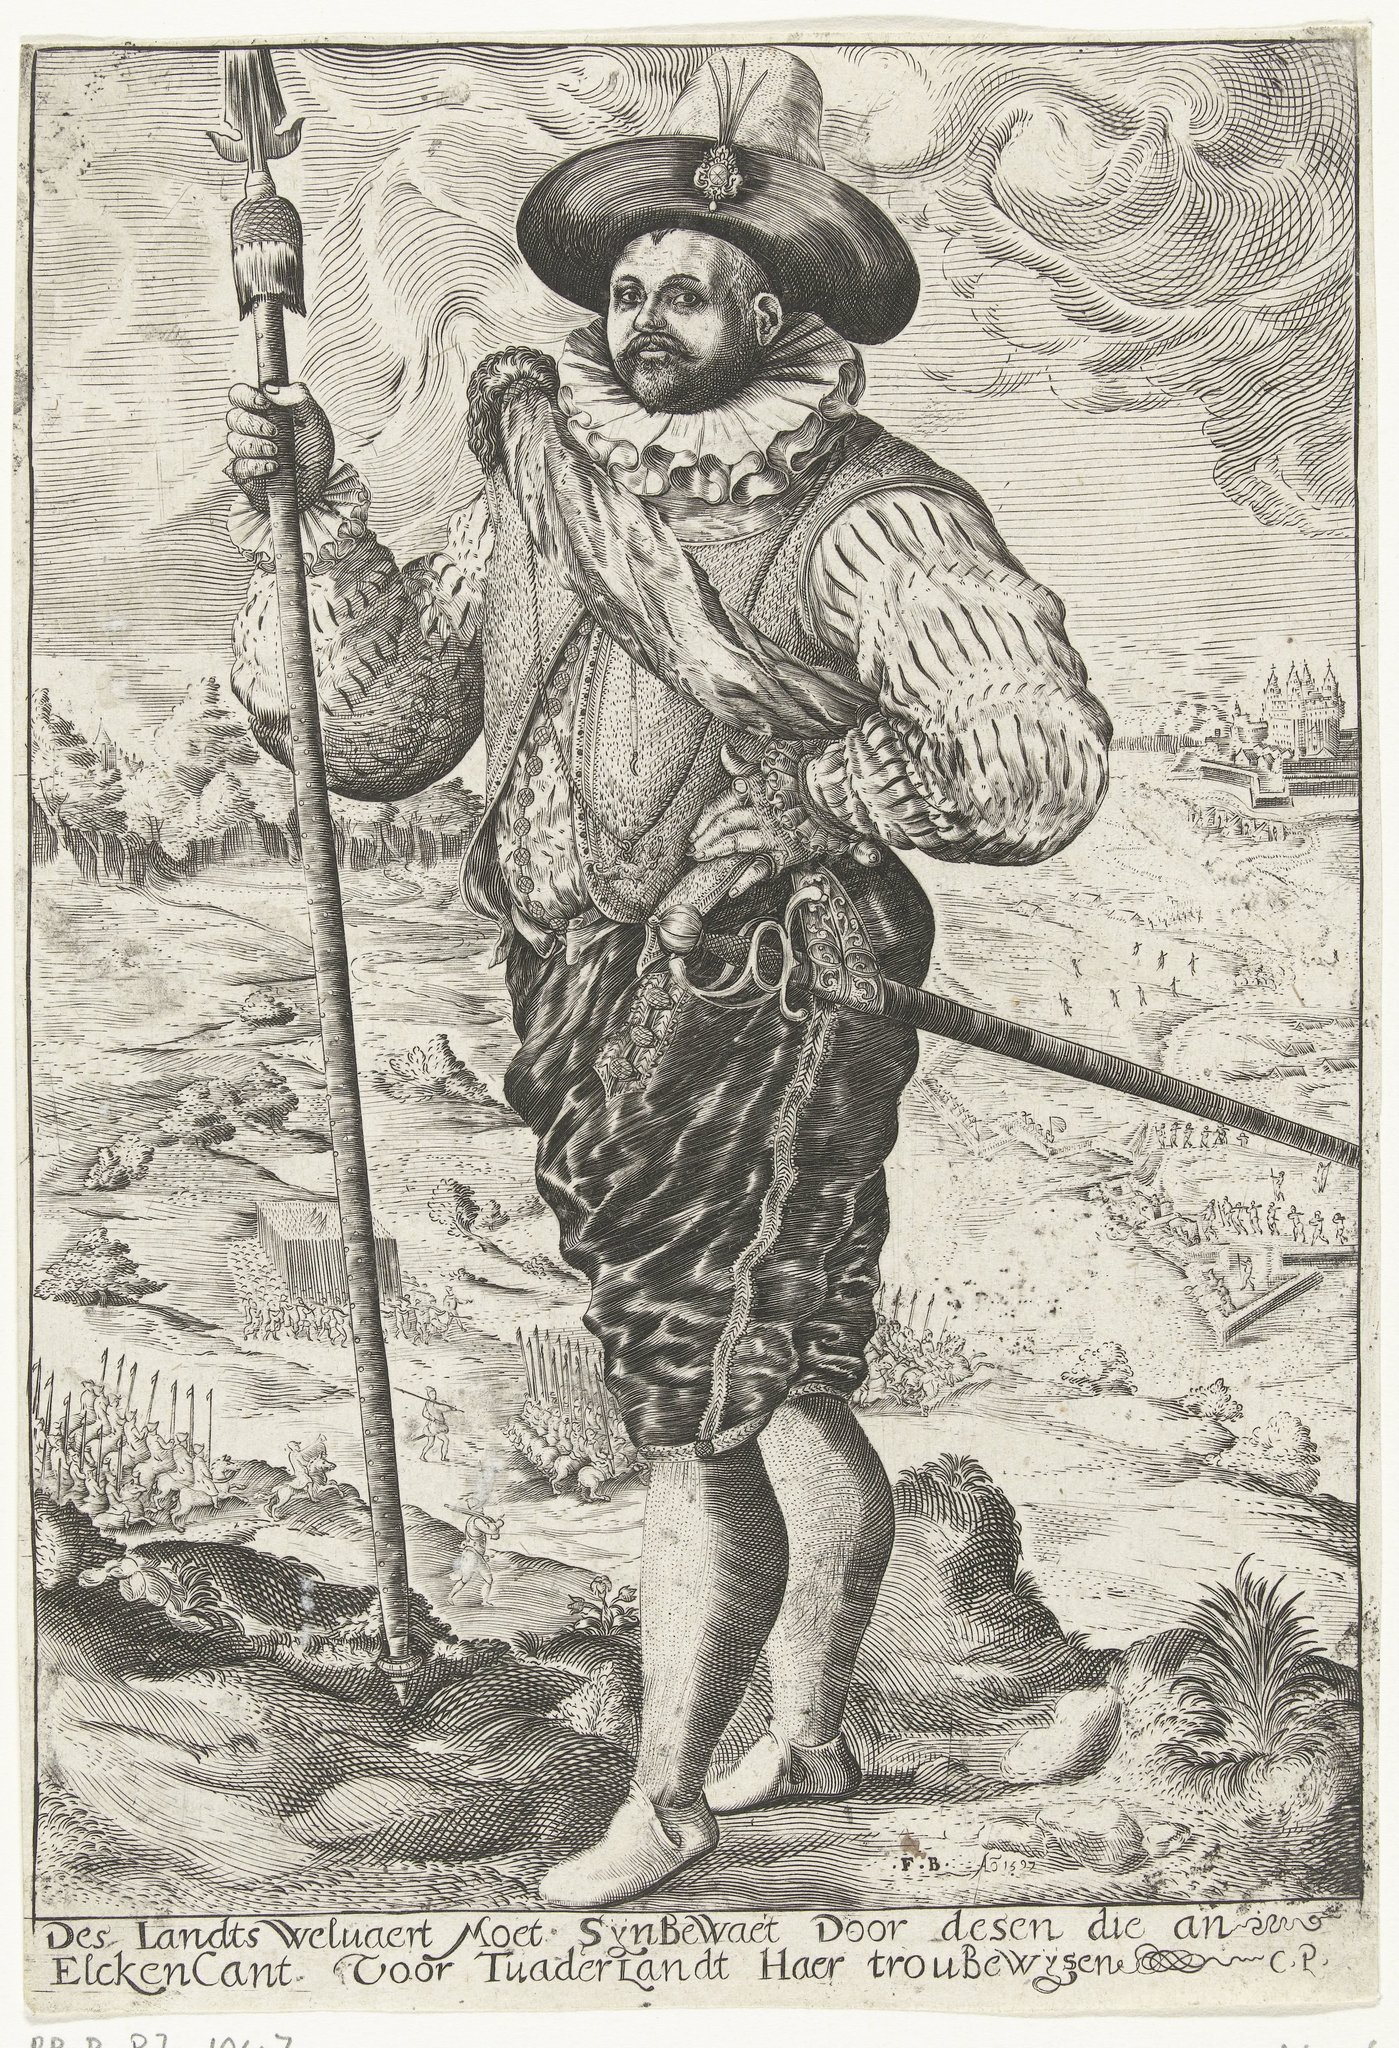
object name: print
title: Soldaat met lans en degen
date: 1597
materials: paper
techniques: engraving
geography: delft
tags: siege, position war, the soldier; the soldier's life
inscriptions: collector's mark: Lugt 2228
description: Portret van een soldaat met lans en degen ten voeten uit. Op de achtergrond is de belegering van een stad te zien. Onder het portret een vers van twee regels over de trouw van de soldaat, getekend C.P.